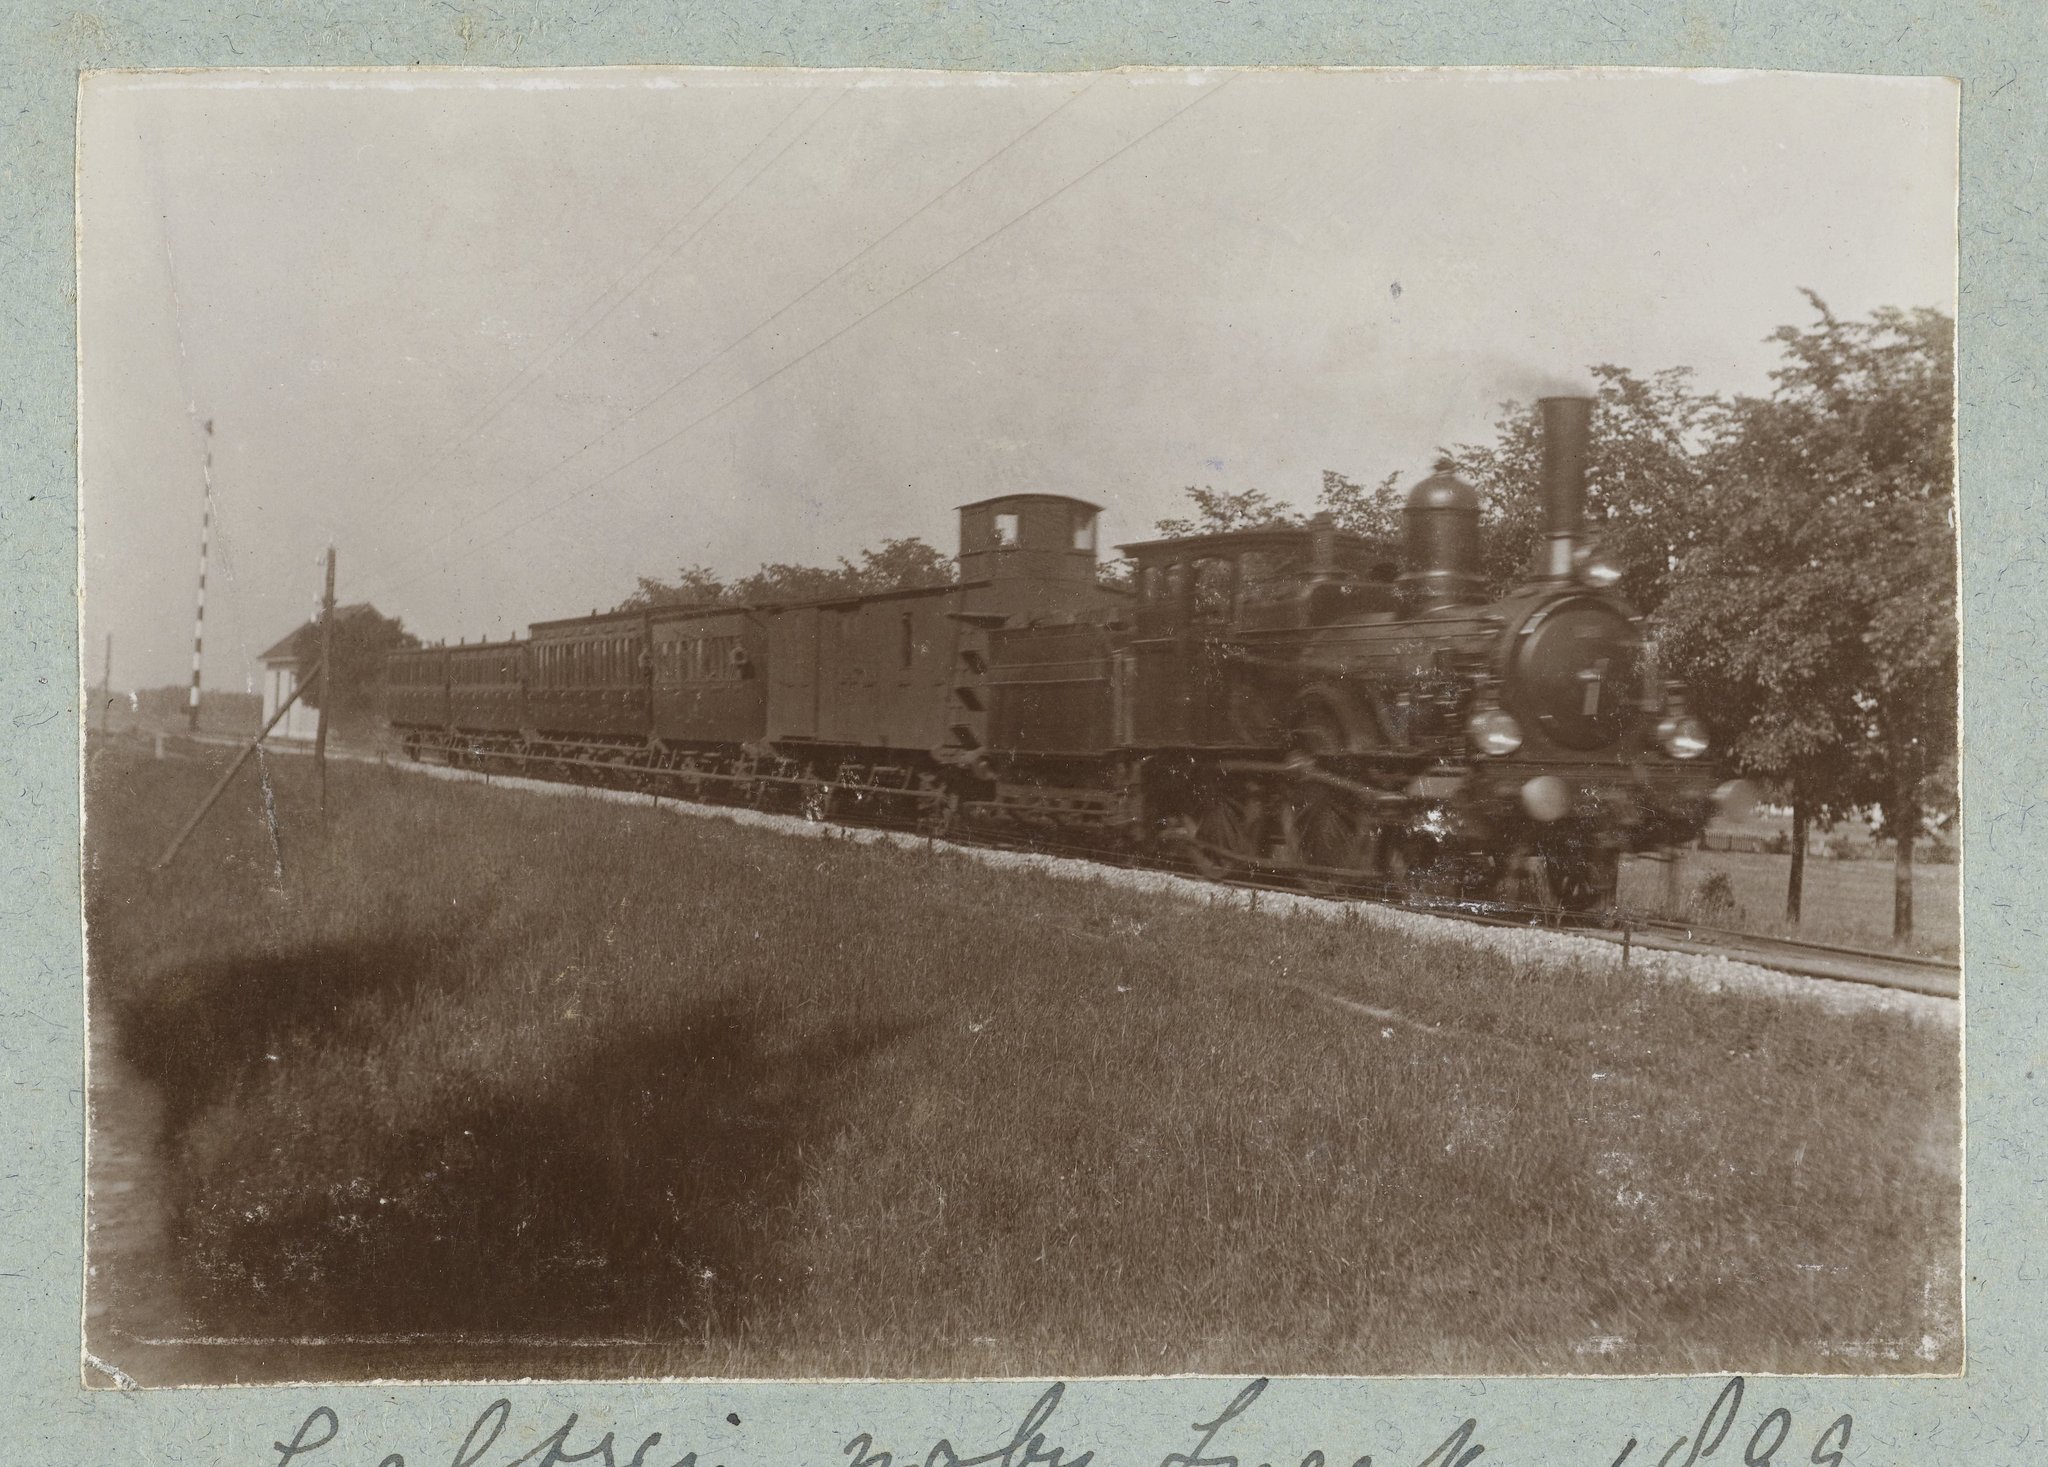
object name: photograph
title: Photographieën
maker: frits freerks fontein fz.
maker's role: fotograaf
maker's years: 1882-1928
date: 1899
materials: cardboard, paper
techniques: gelatin silver print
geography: netherlands